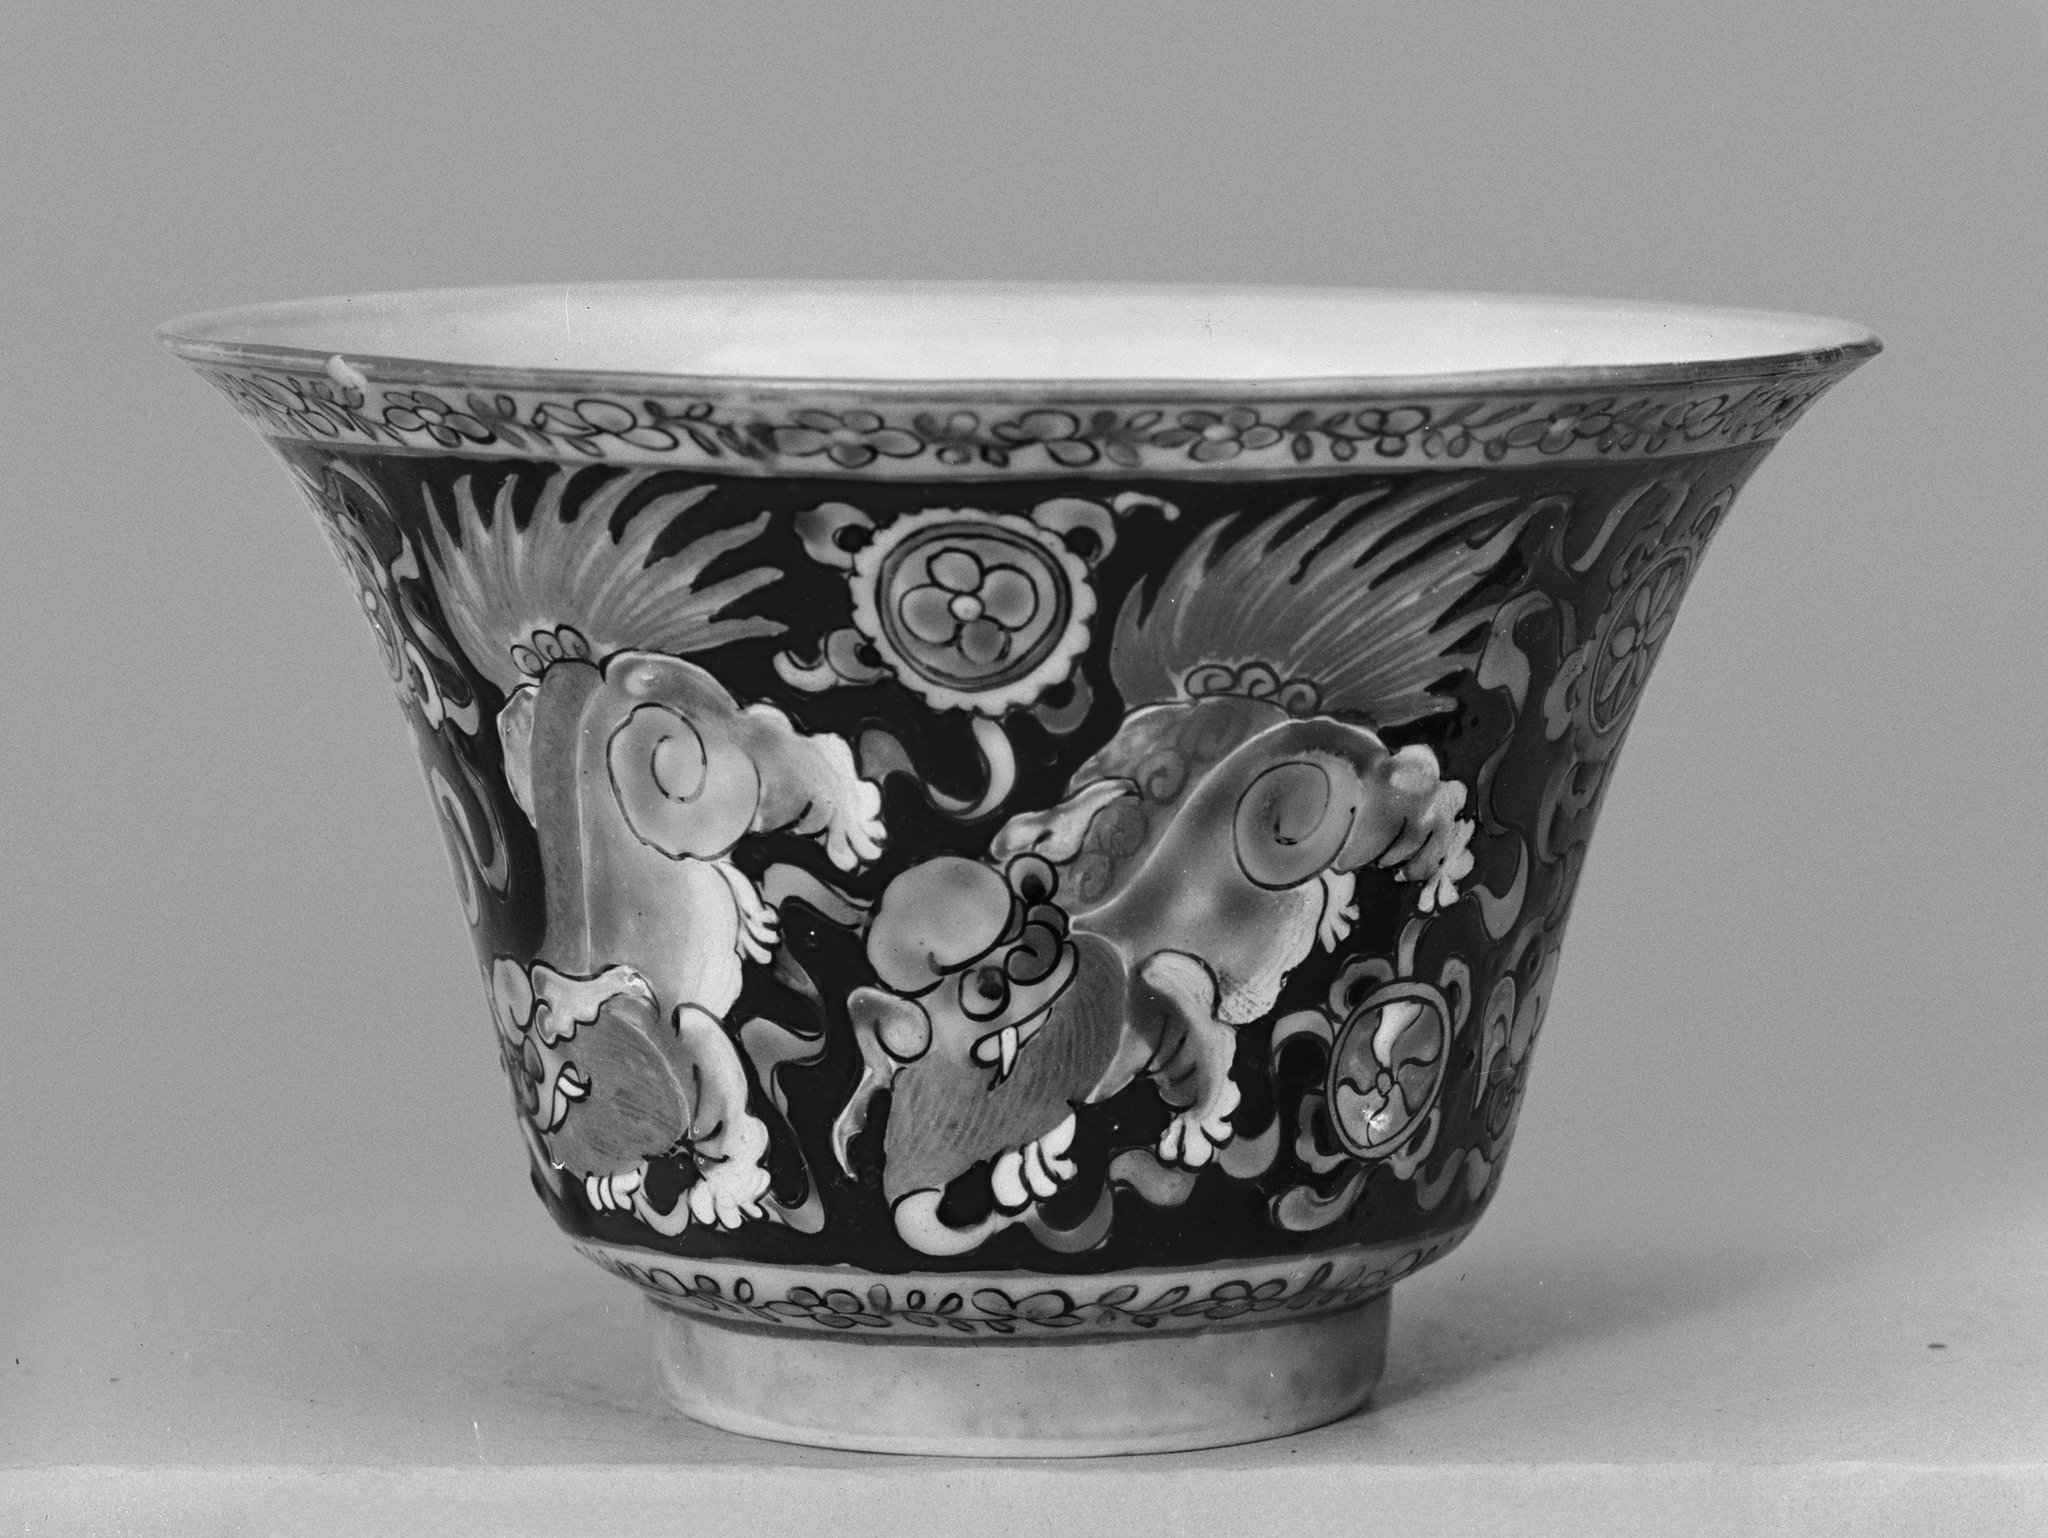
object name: cup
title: Cup with lions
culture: chinese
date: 1801-1900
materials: enamel, porcelain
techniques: overglaze, painting, polychrome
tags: lions